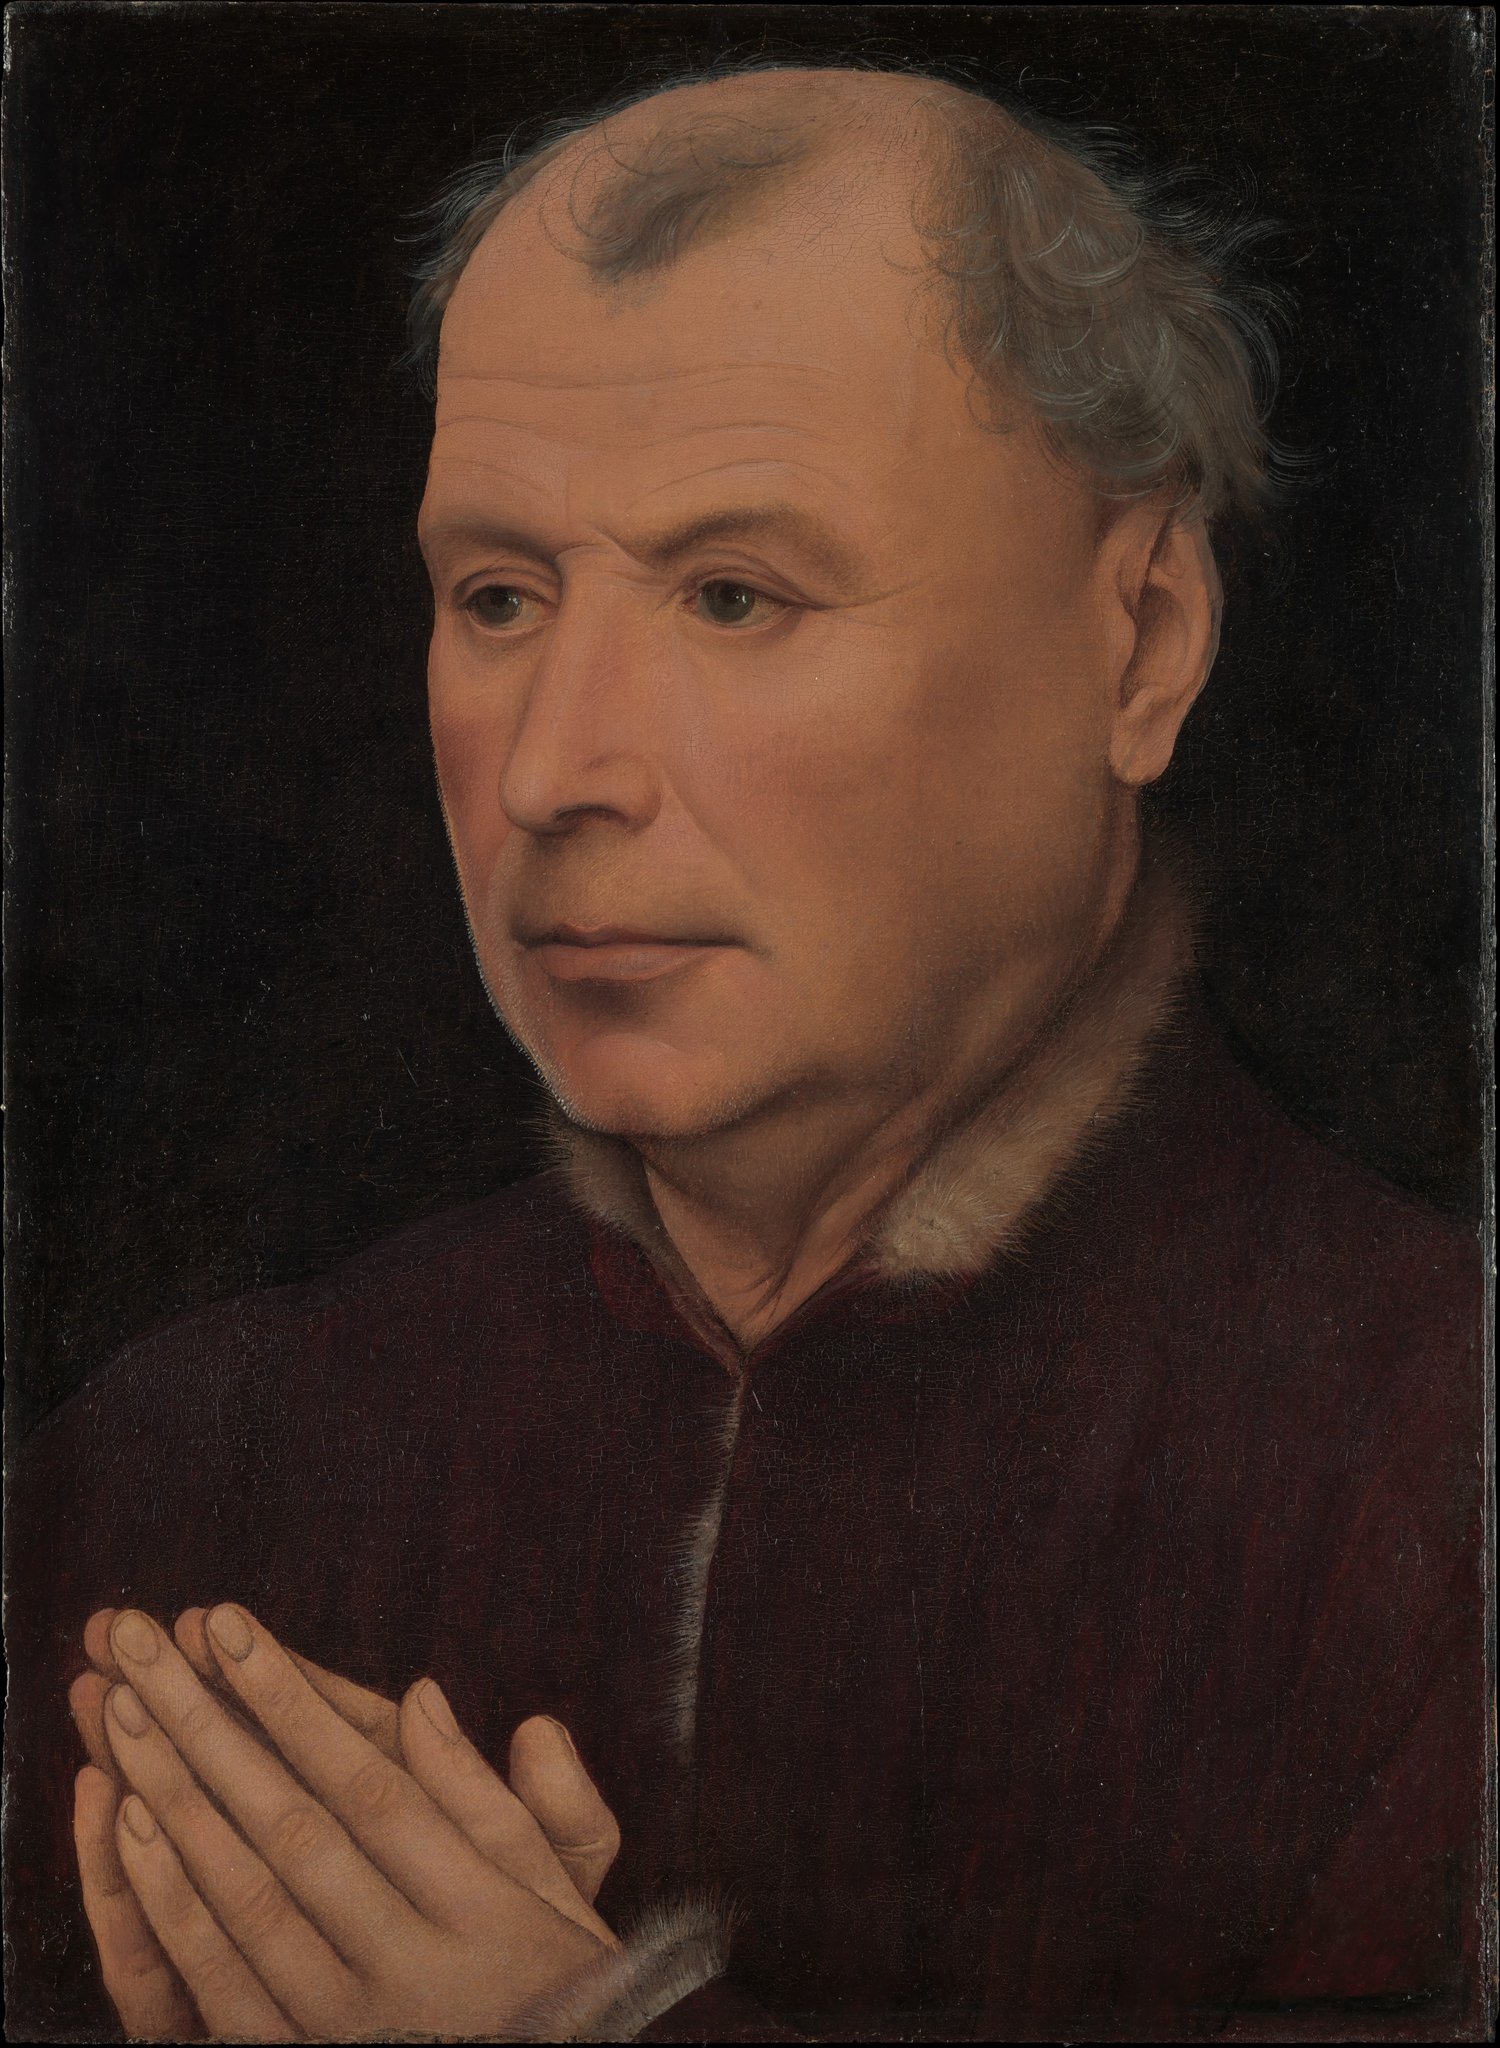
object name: painting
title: Man in Prayer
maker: rogier van der weyden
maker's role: artist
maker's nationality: netherlandish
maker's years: 1399-1464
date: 1440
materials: oil, wood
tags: men,portraits